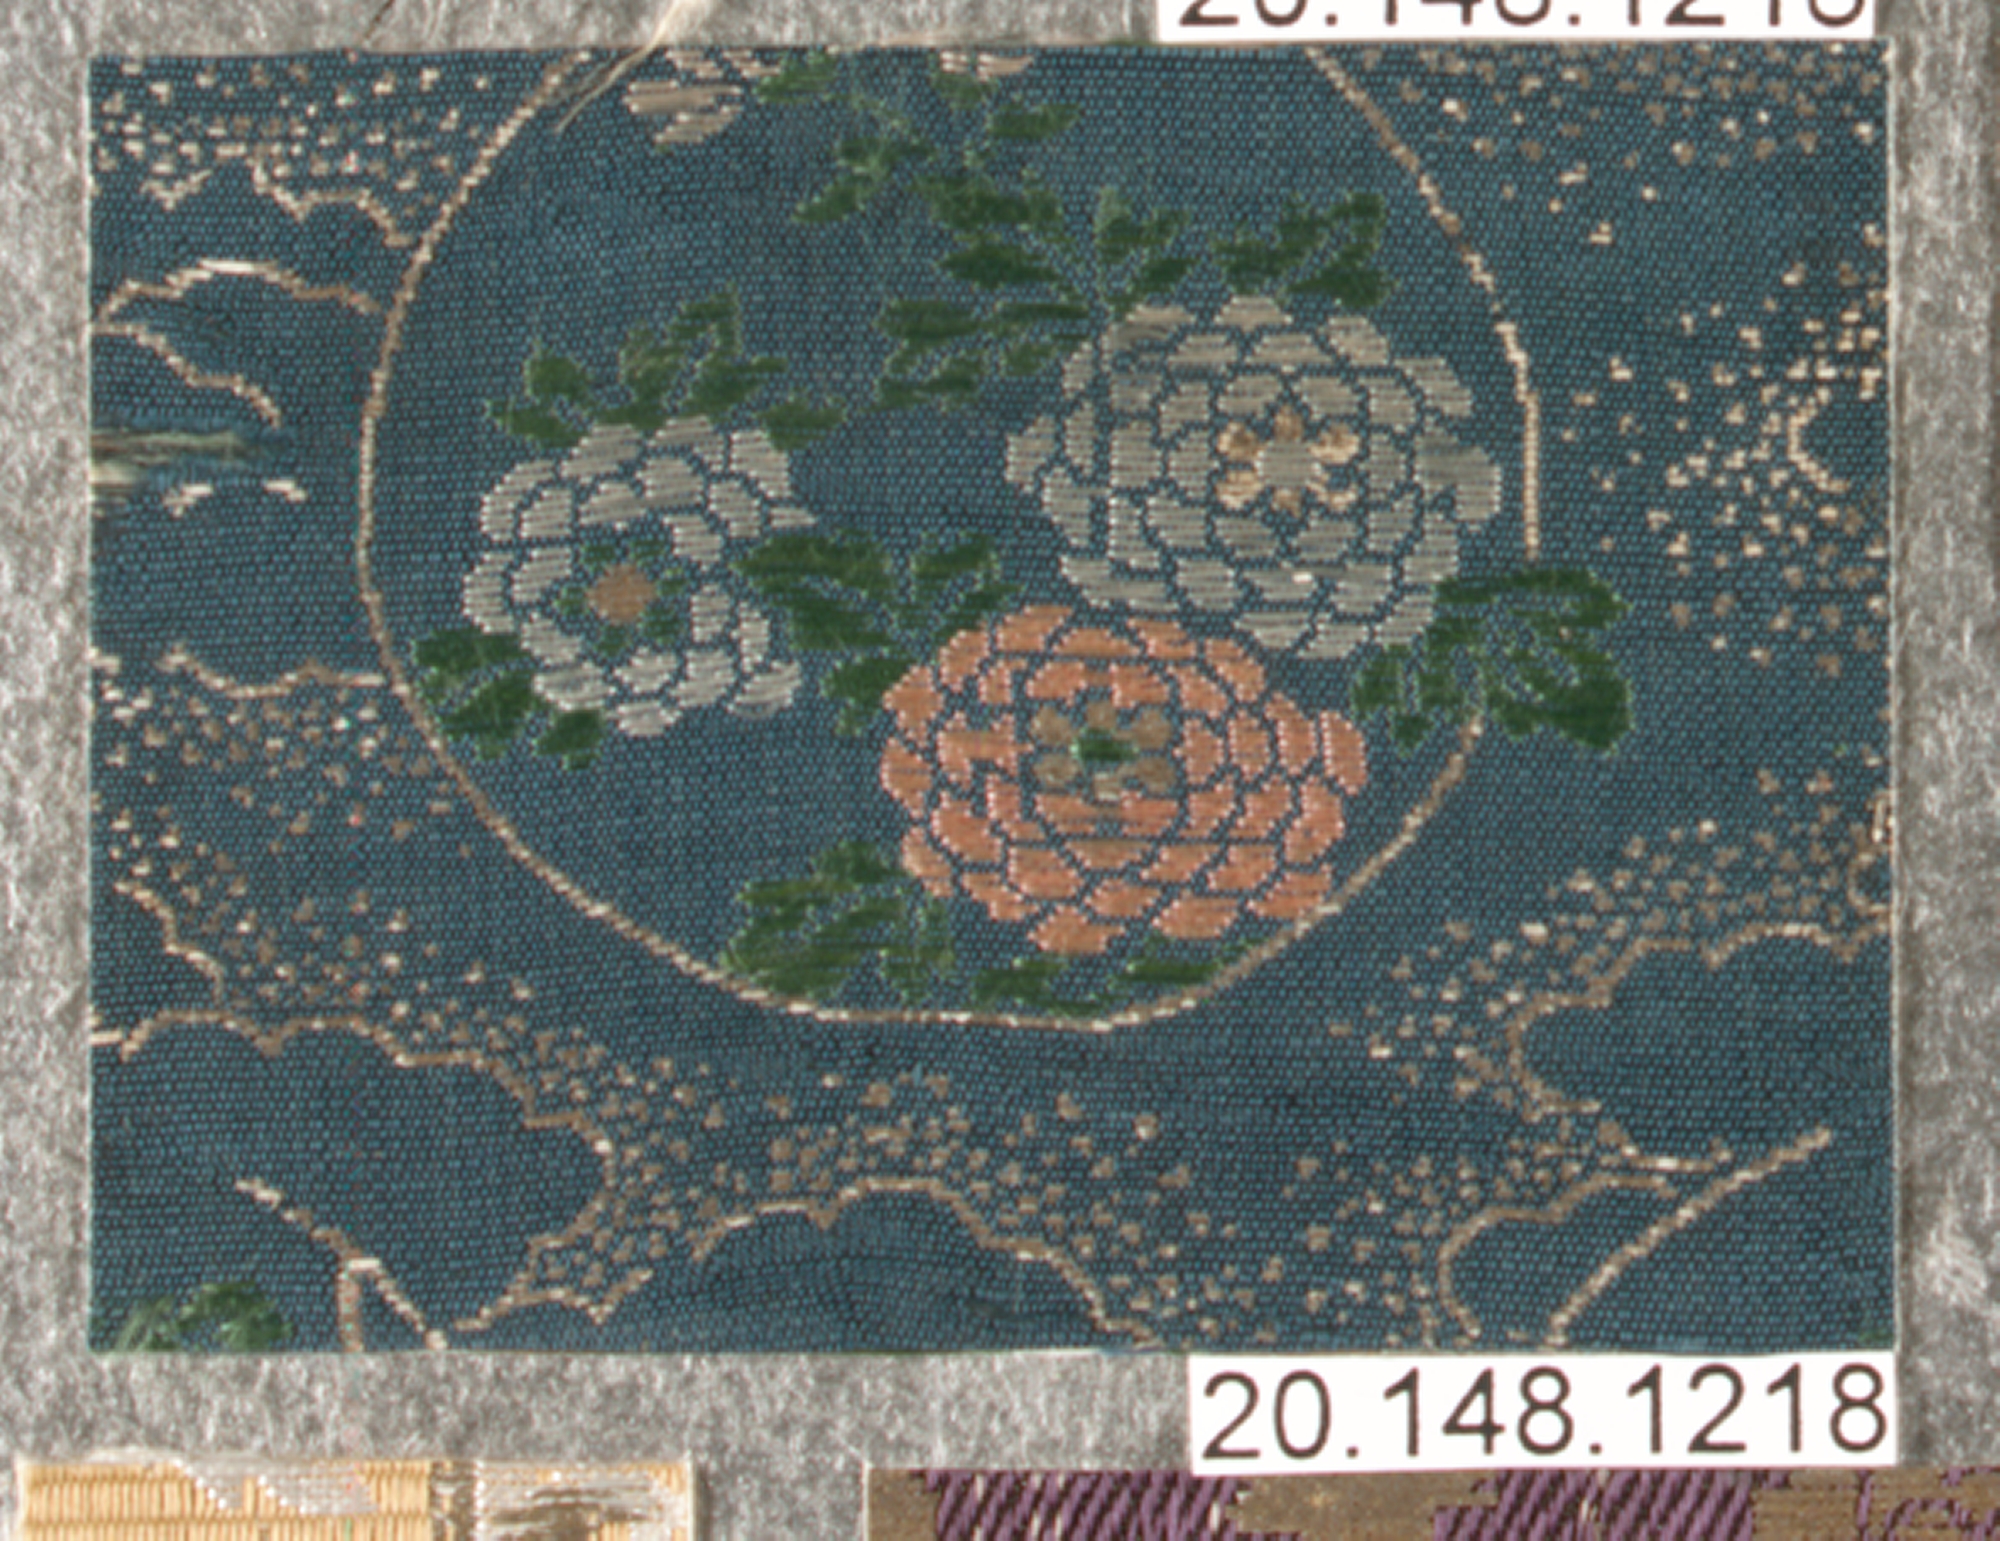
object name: piece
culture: japanese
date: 1801-1900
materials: silk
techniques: compound weave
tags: flowers